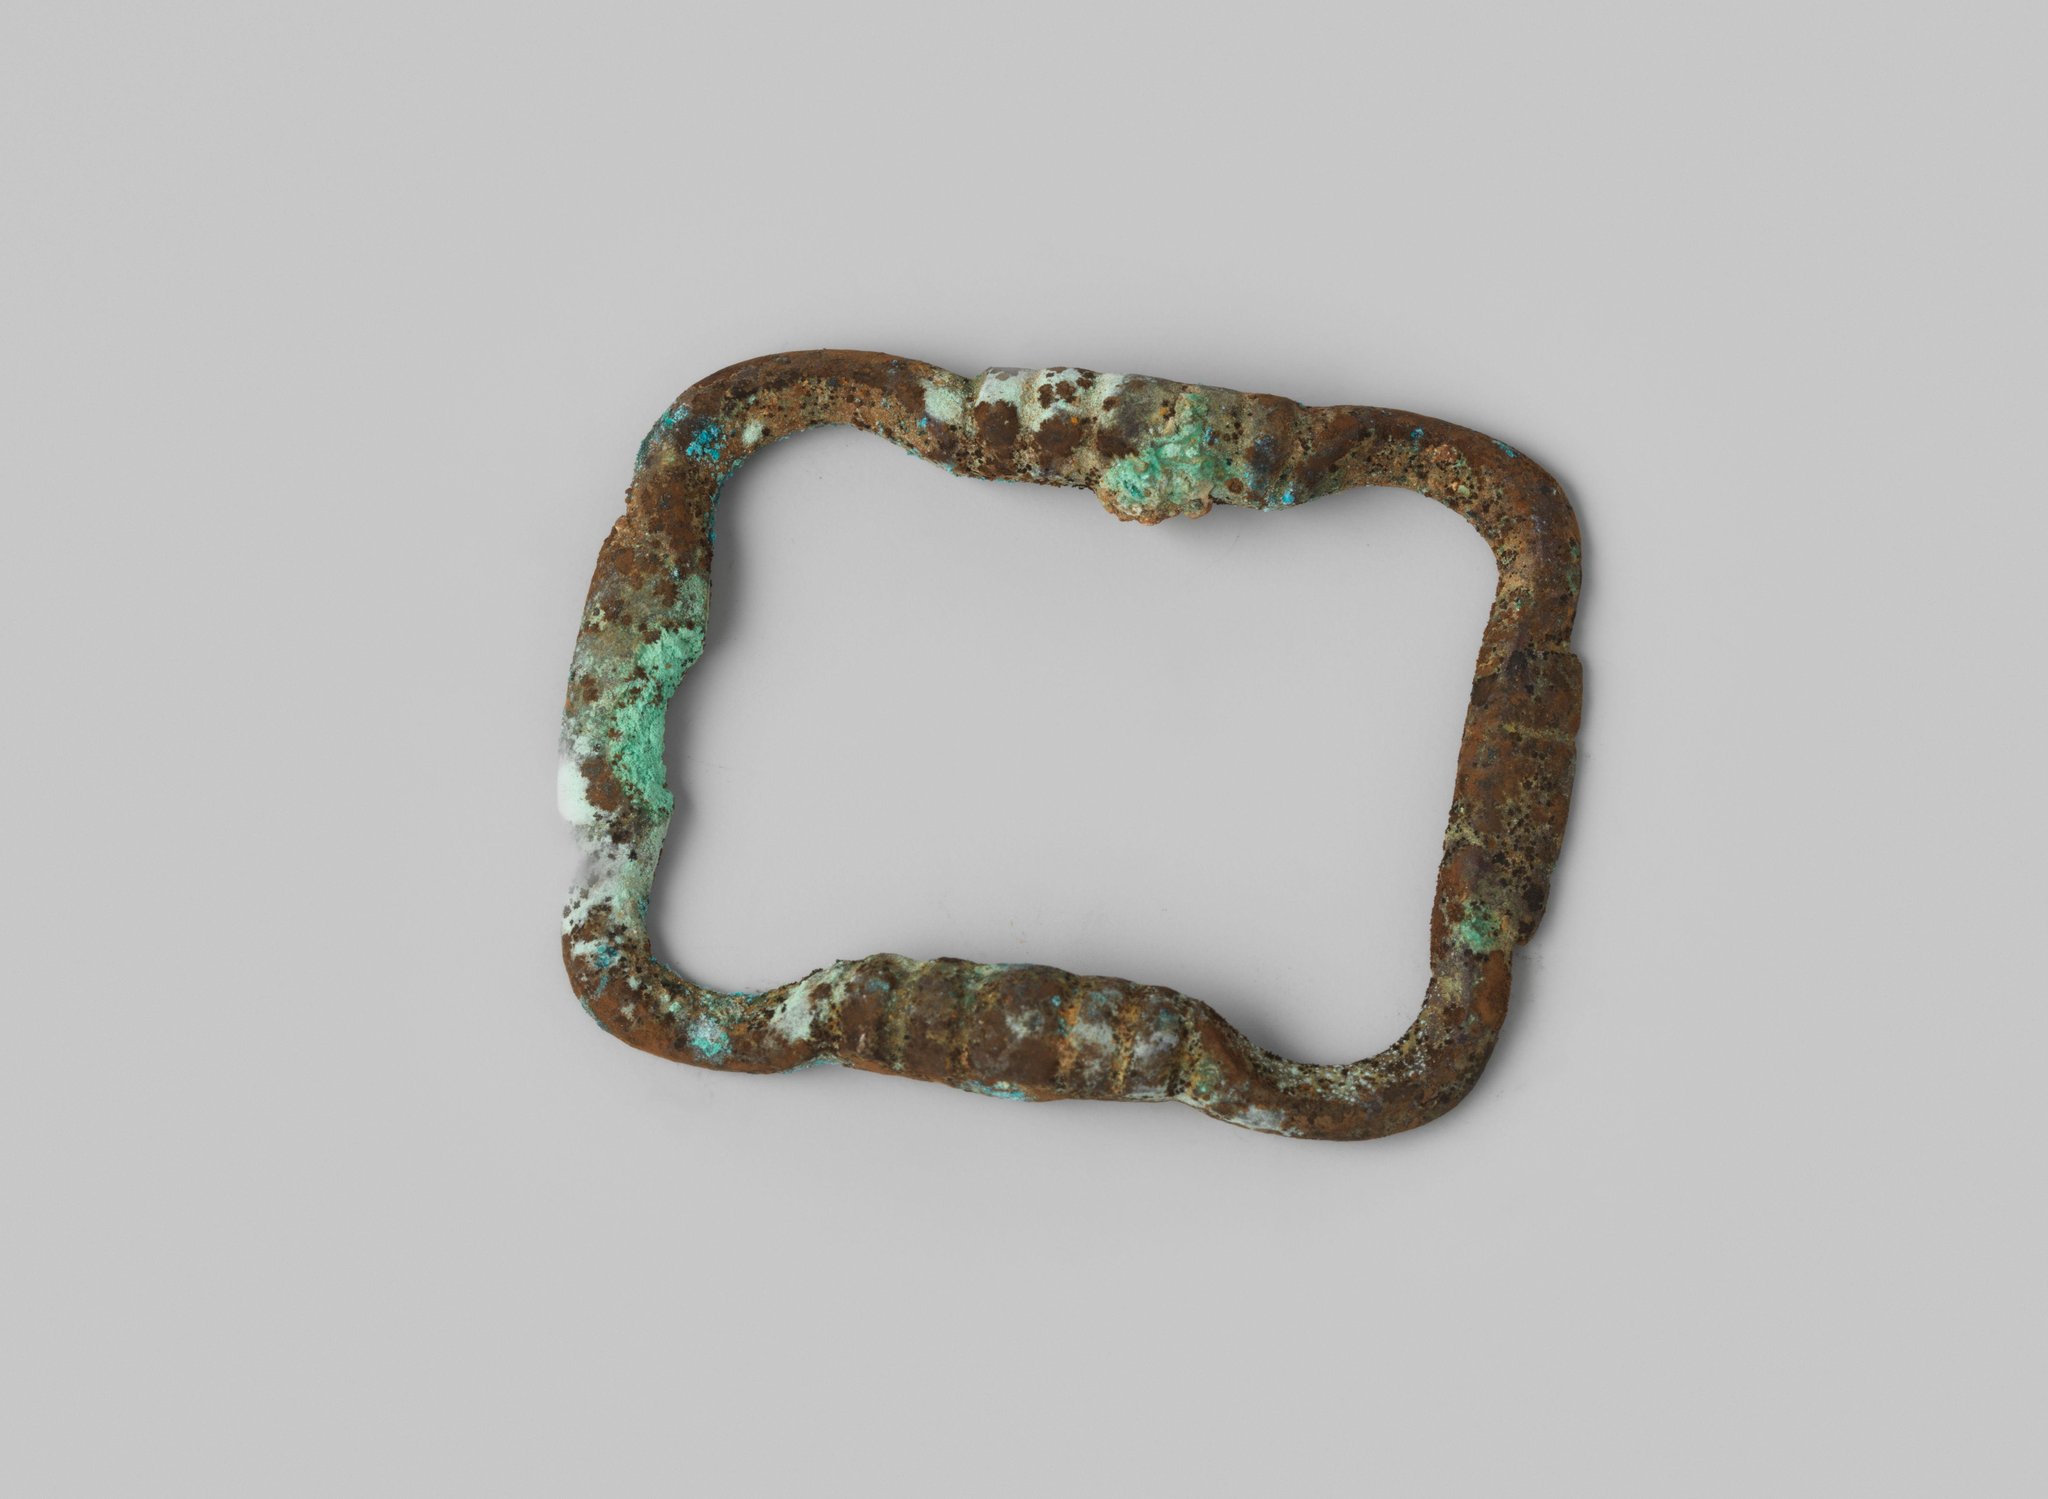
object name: shoe buckle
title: Schoengesp uit het wrak van de Oost-Indiëvaarder Hollandia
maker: Anonymous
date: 1700-1743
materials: copper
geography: netherlands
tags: verenigde oostindische compagnie, hollandia (schip), annet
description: Buckle, chape buckle, shoe buckle; ring, fluted moulding.